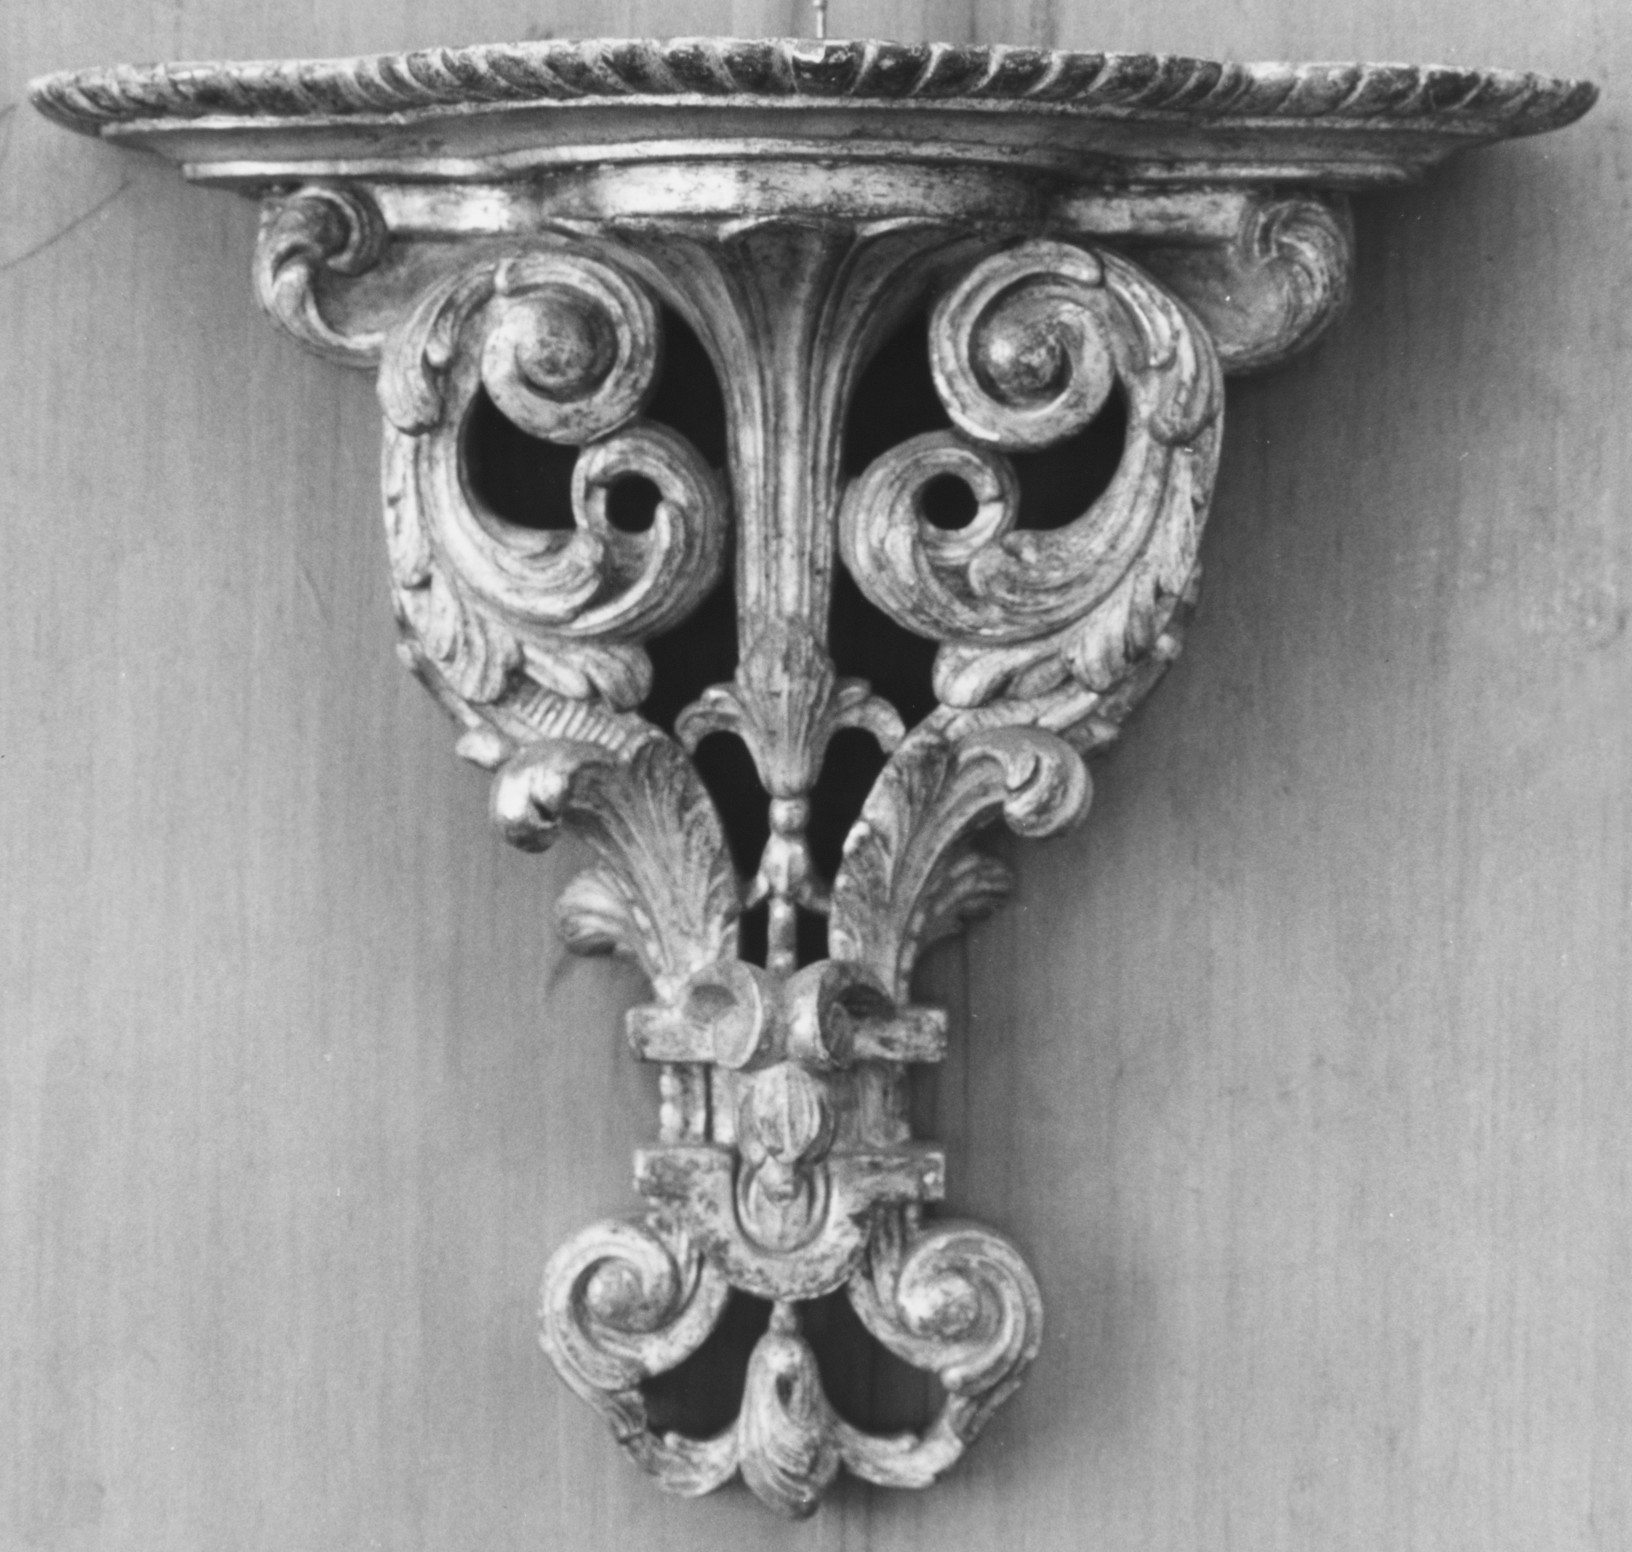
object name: wall bracket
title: Pair of wall brackets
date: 1725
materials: wood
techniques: carving, gilding